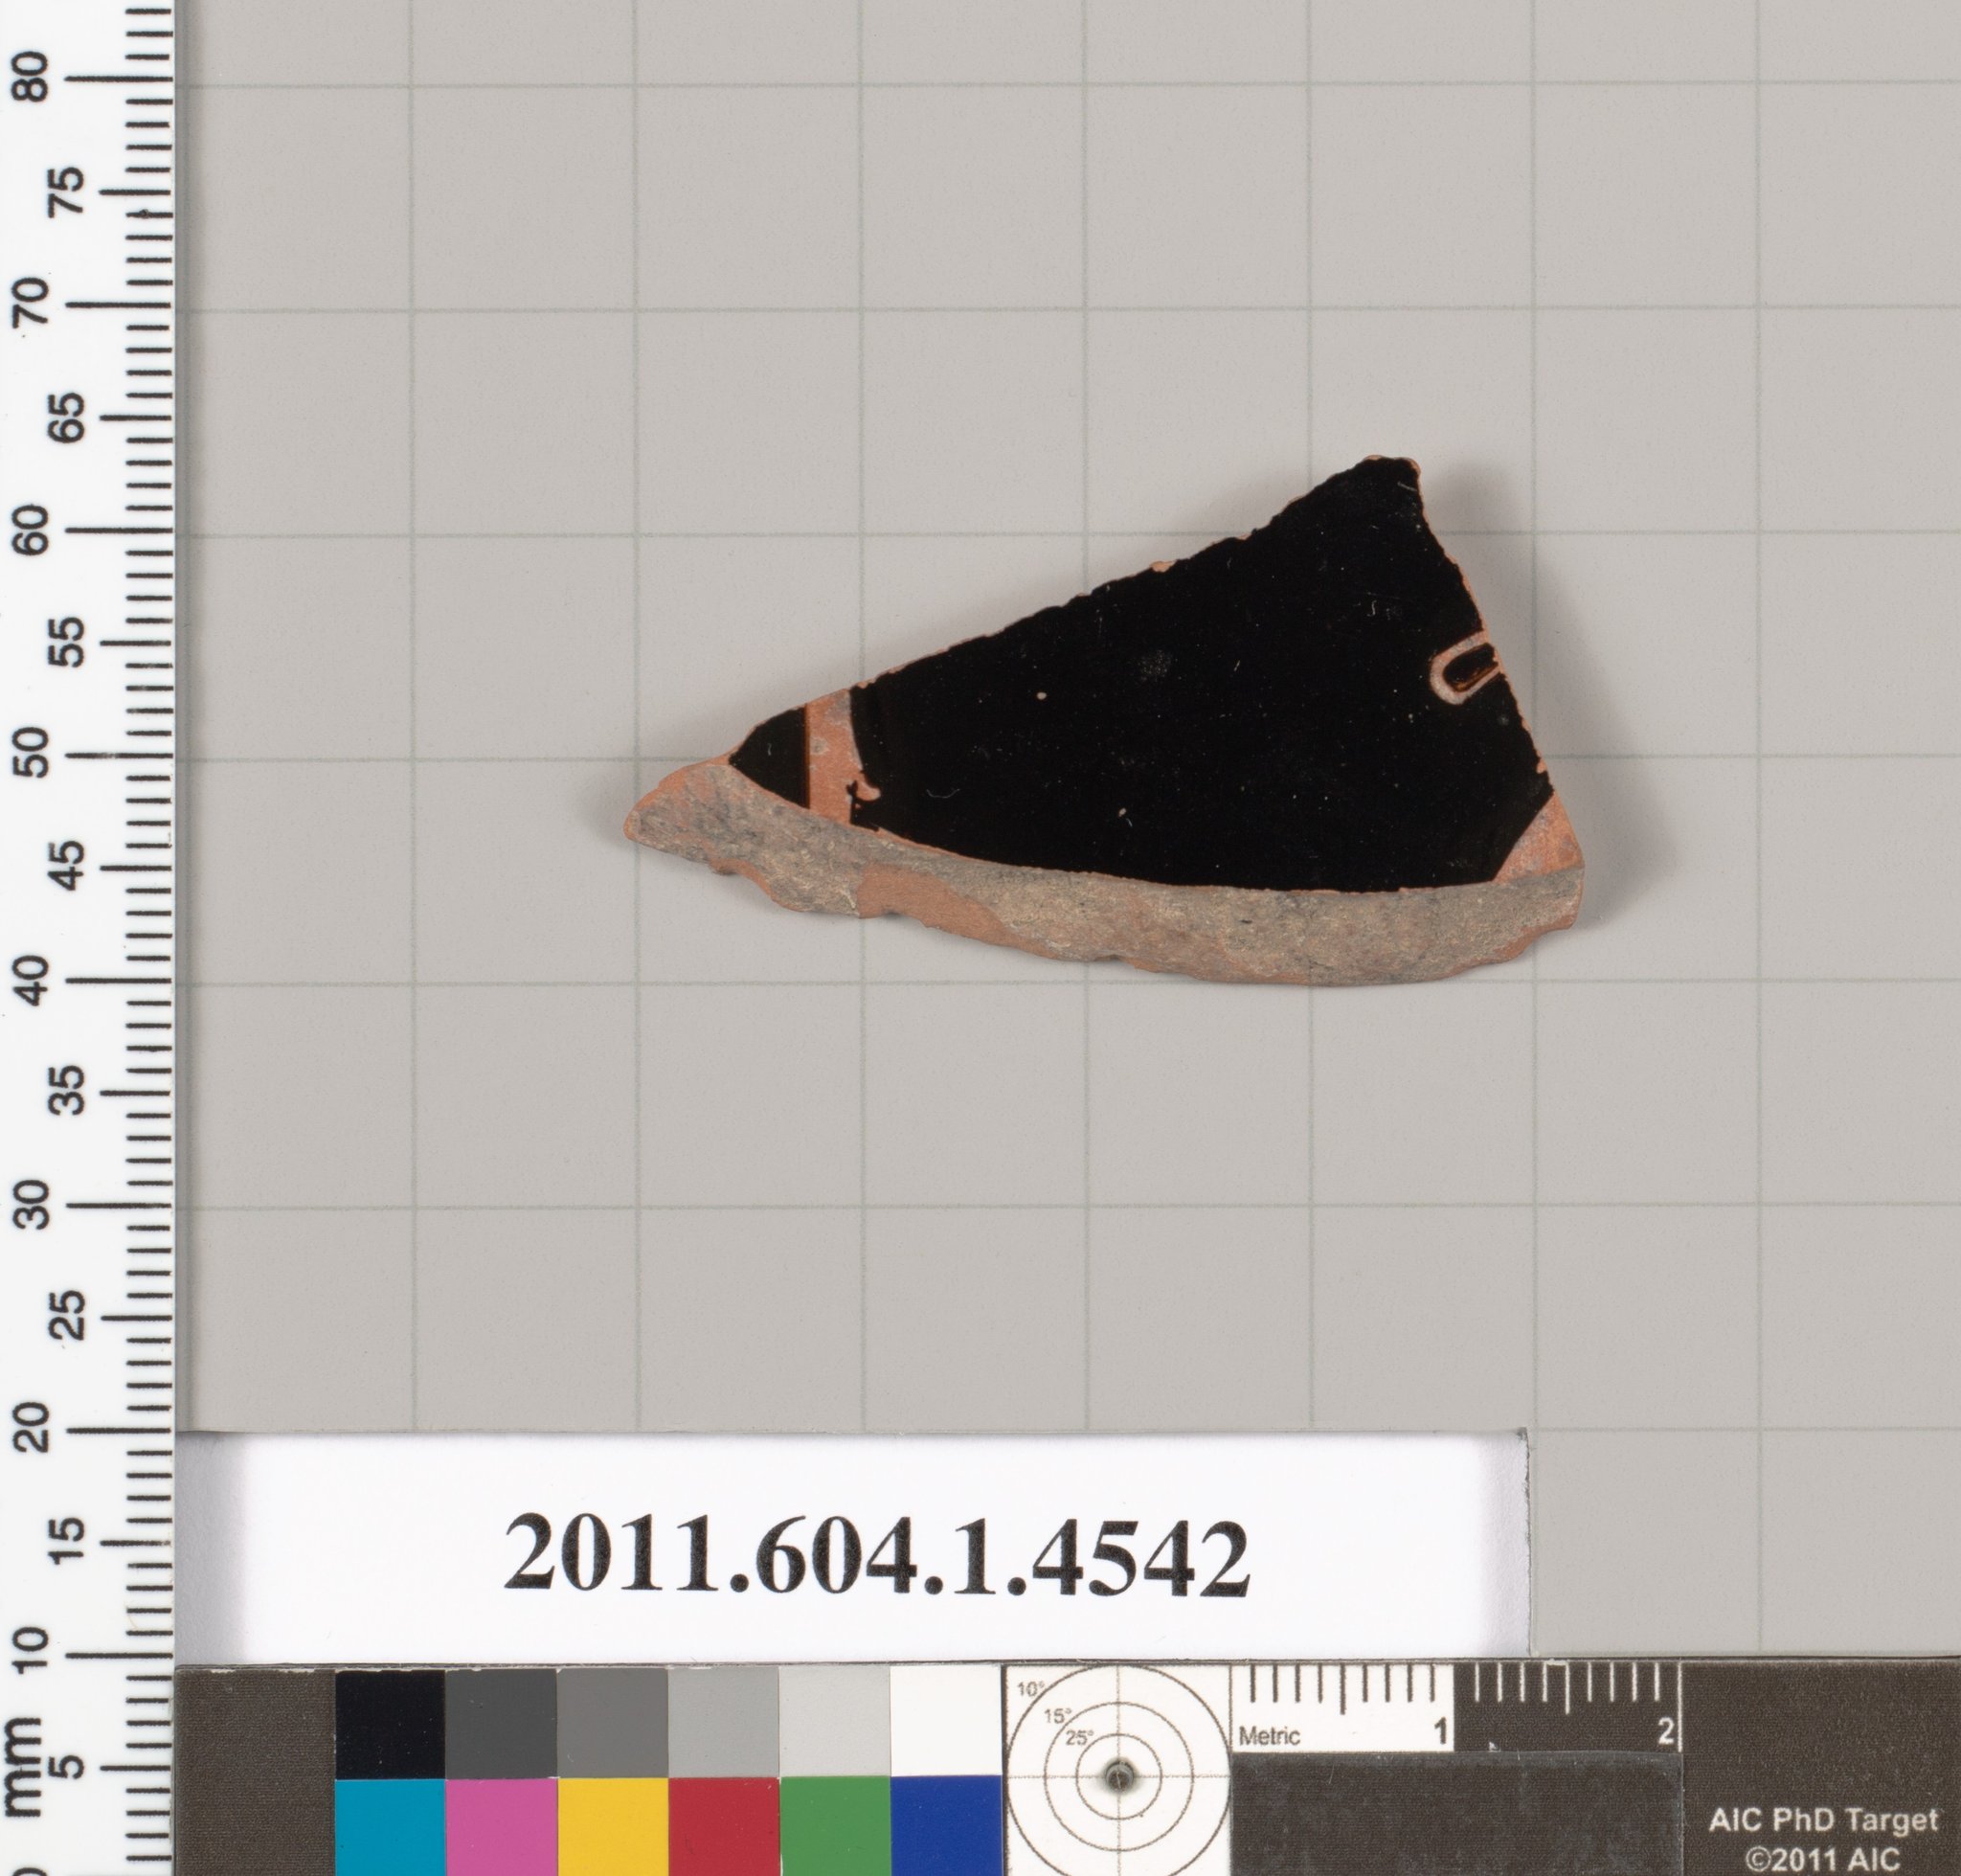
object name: kylix fragment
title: Terracotta fragment of a kylix (drinking cup)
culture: greek, attic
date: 500-480 BCE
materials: terracotta